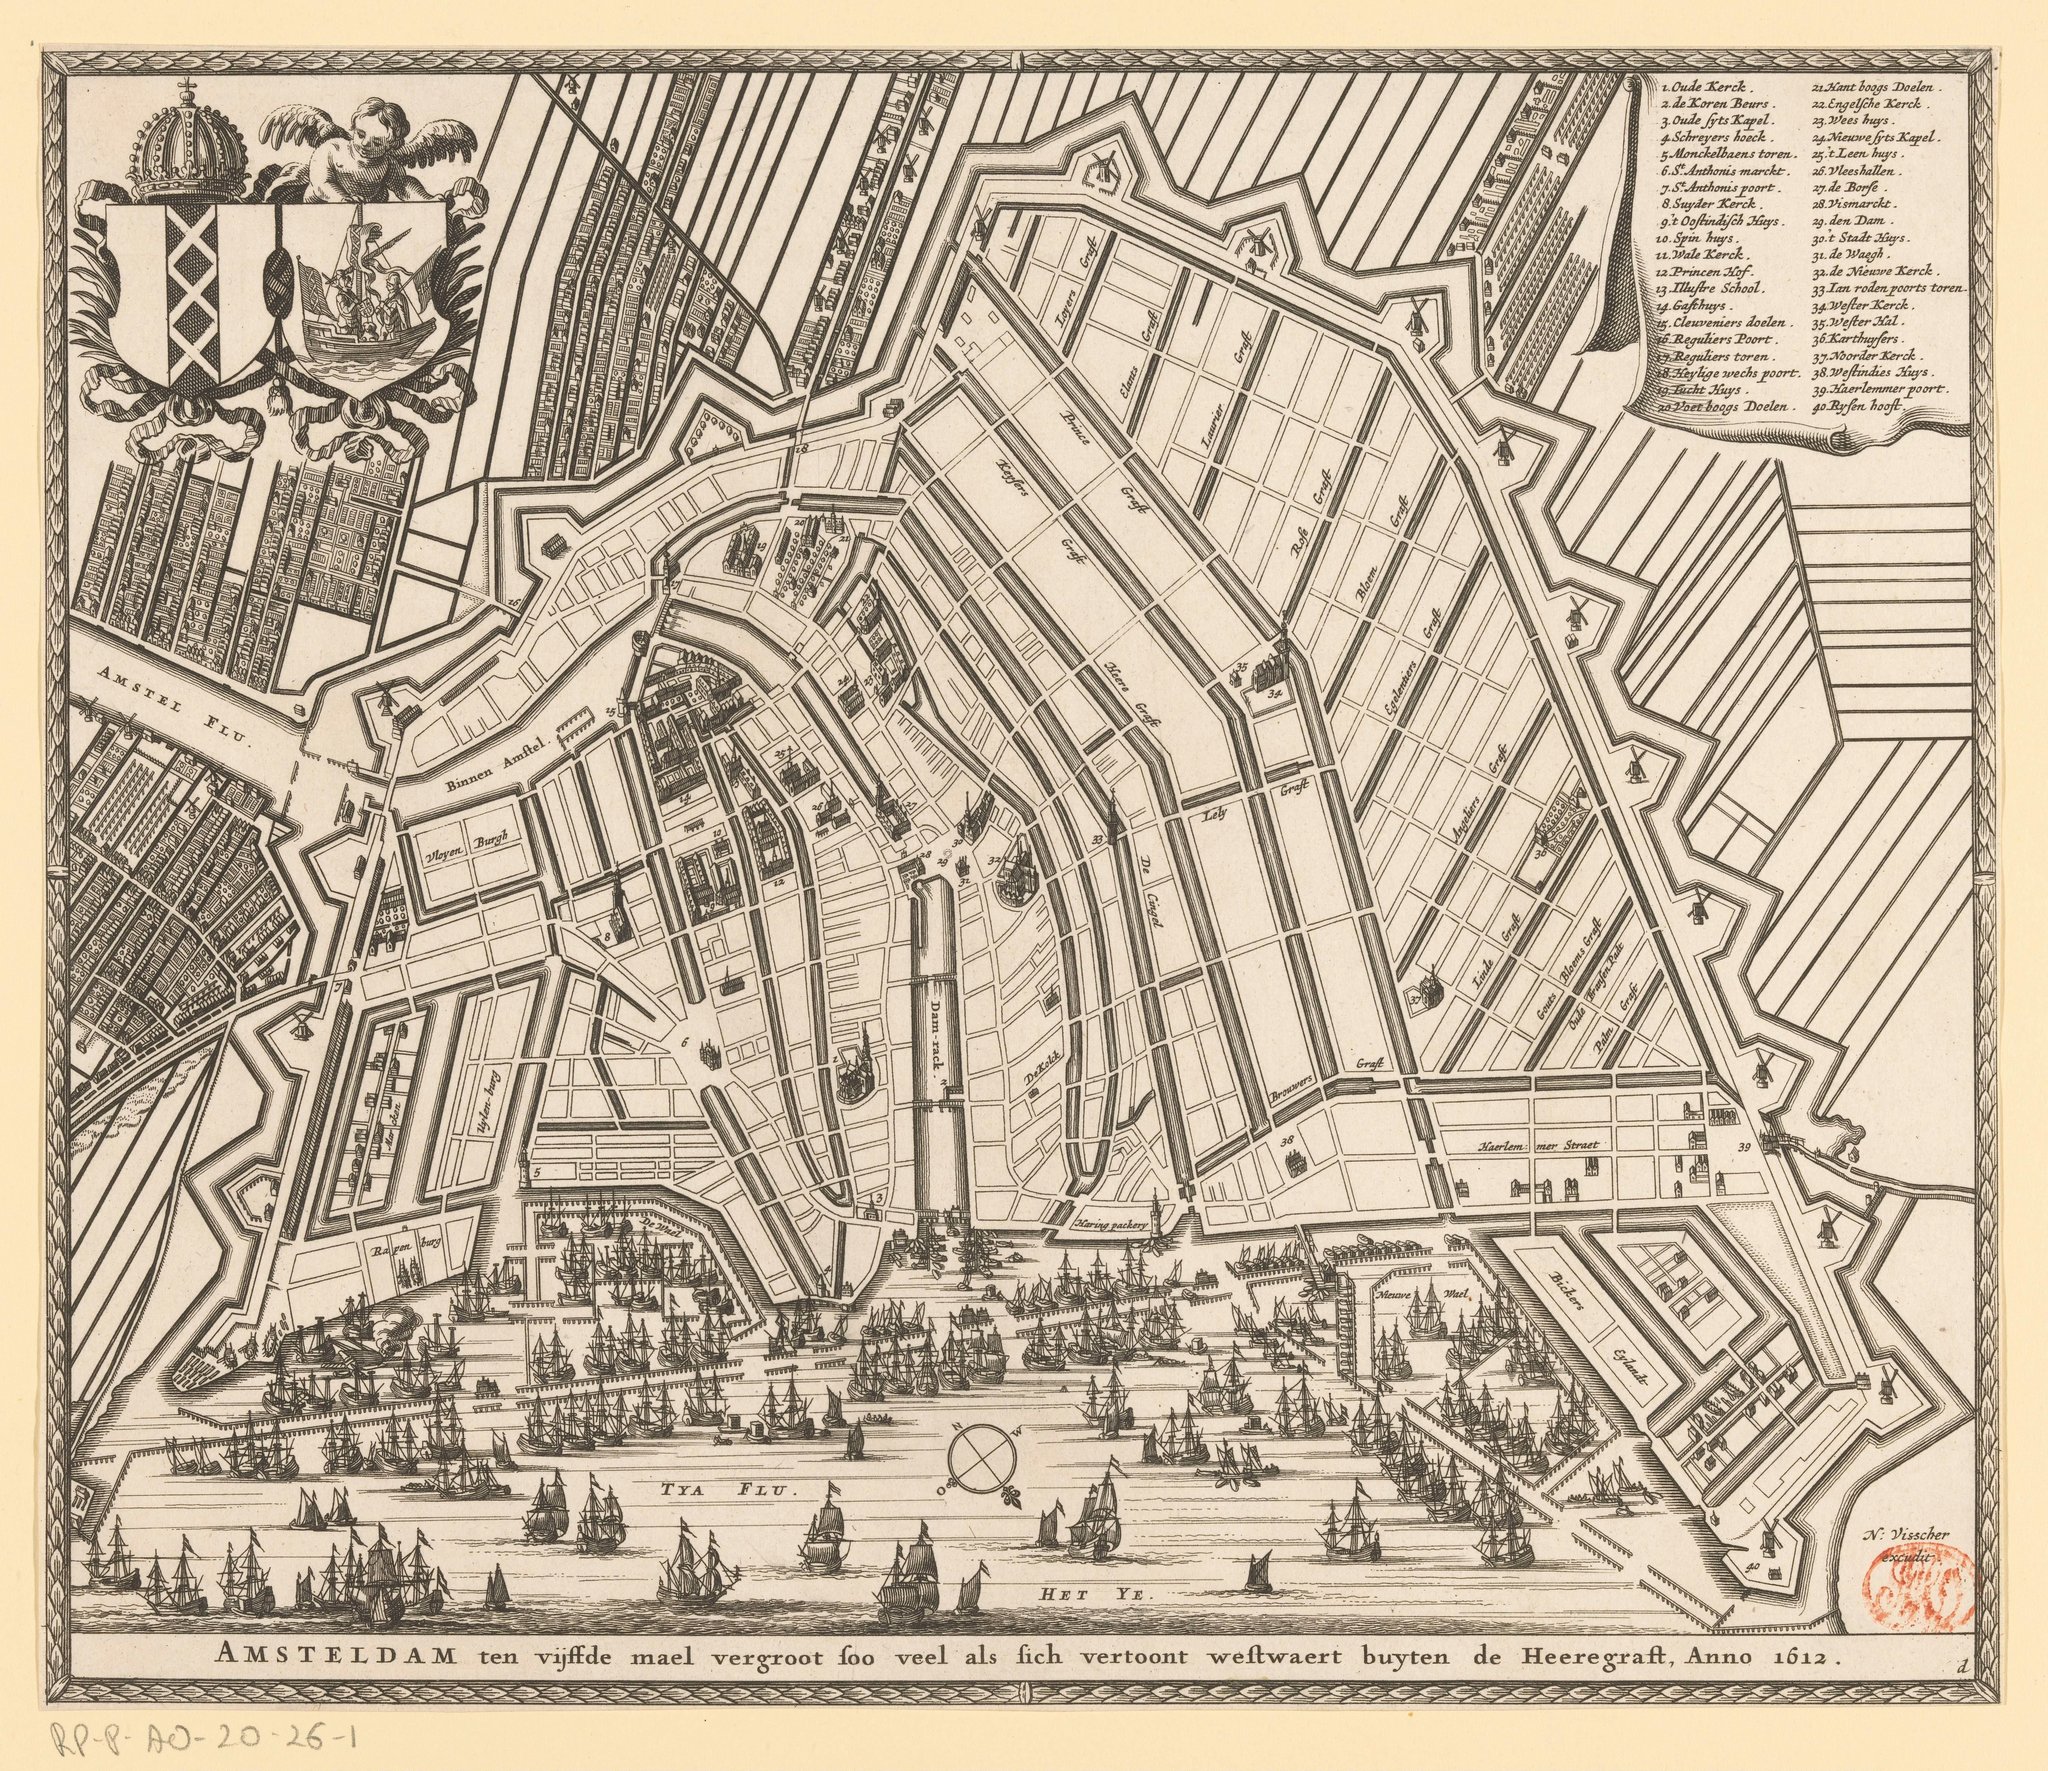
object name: print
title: Amsteldam ten vijffde mael vergroot soo veel als sich vertoont westwaert buyten de Heeregraft, Anno 1612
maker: pieter hendricksz. schut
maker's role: print maker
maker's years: 1618-1660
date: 1662-1720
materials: paper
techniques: engraving, etching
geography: amsterdam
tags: coat of arms (as symbol of the state, etc.) (+ city; municipal), seal (as symbol of the state, etc.) (+ city; municipal), maps of cities, amsterdam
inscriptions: collector's mark: Lugt 195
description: Plattegrond van Amsterdam zoals het er na de uitbreiding in 1612 uit zou hebben gezien. Met gebouwen in vogelvluchtperspectief. Linksboven het wapen en zegel van de stad. Rechtsboven een cartouche met de legenda 1-40. Rechtsonder gemerkt: d. Oriëntatie: zuidzuidwest boven.